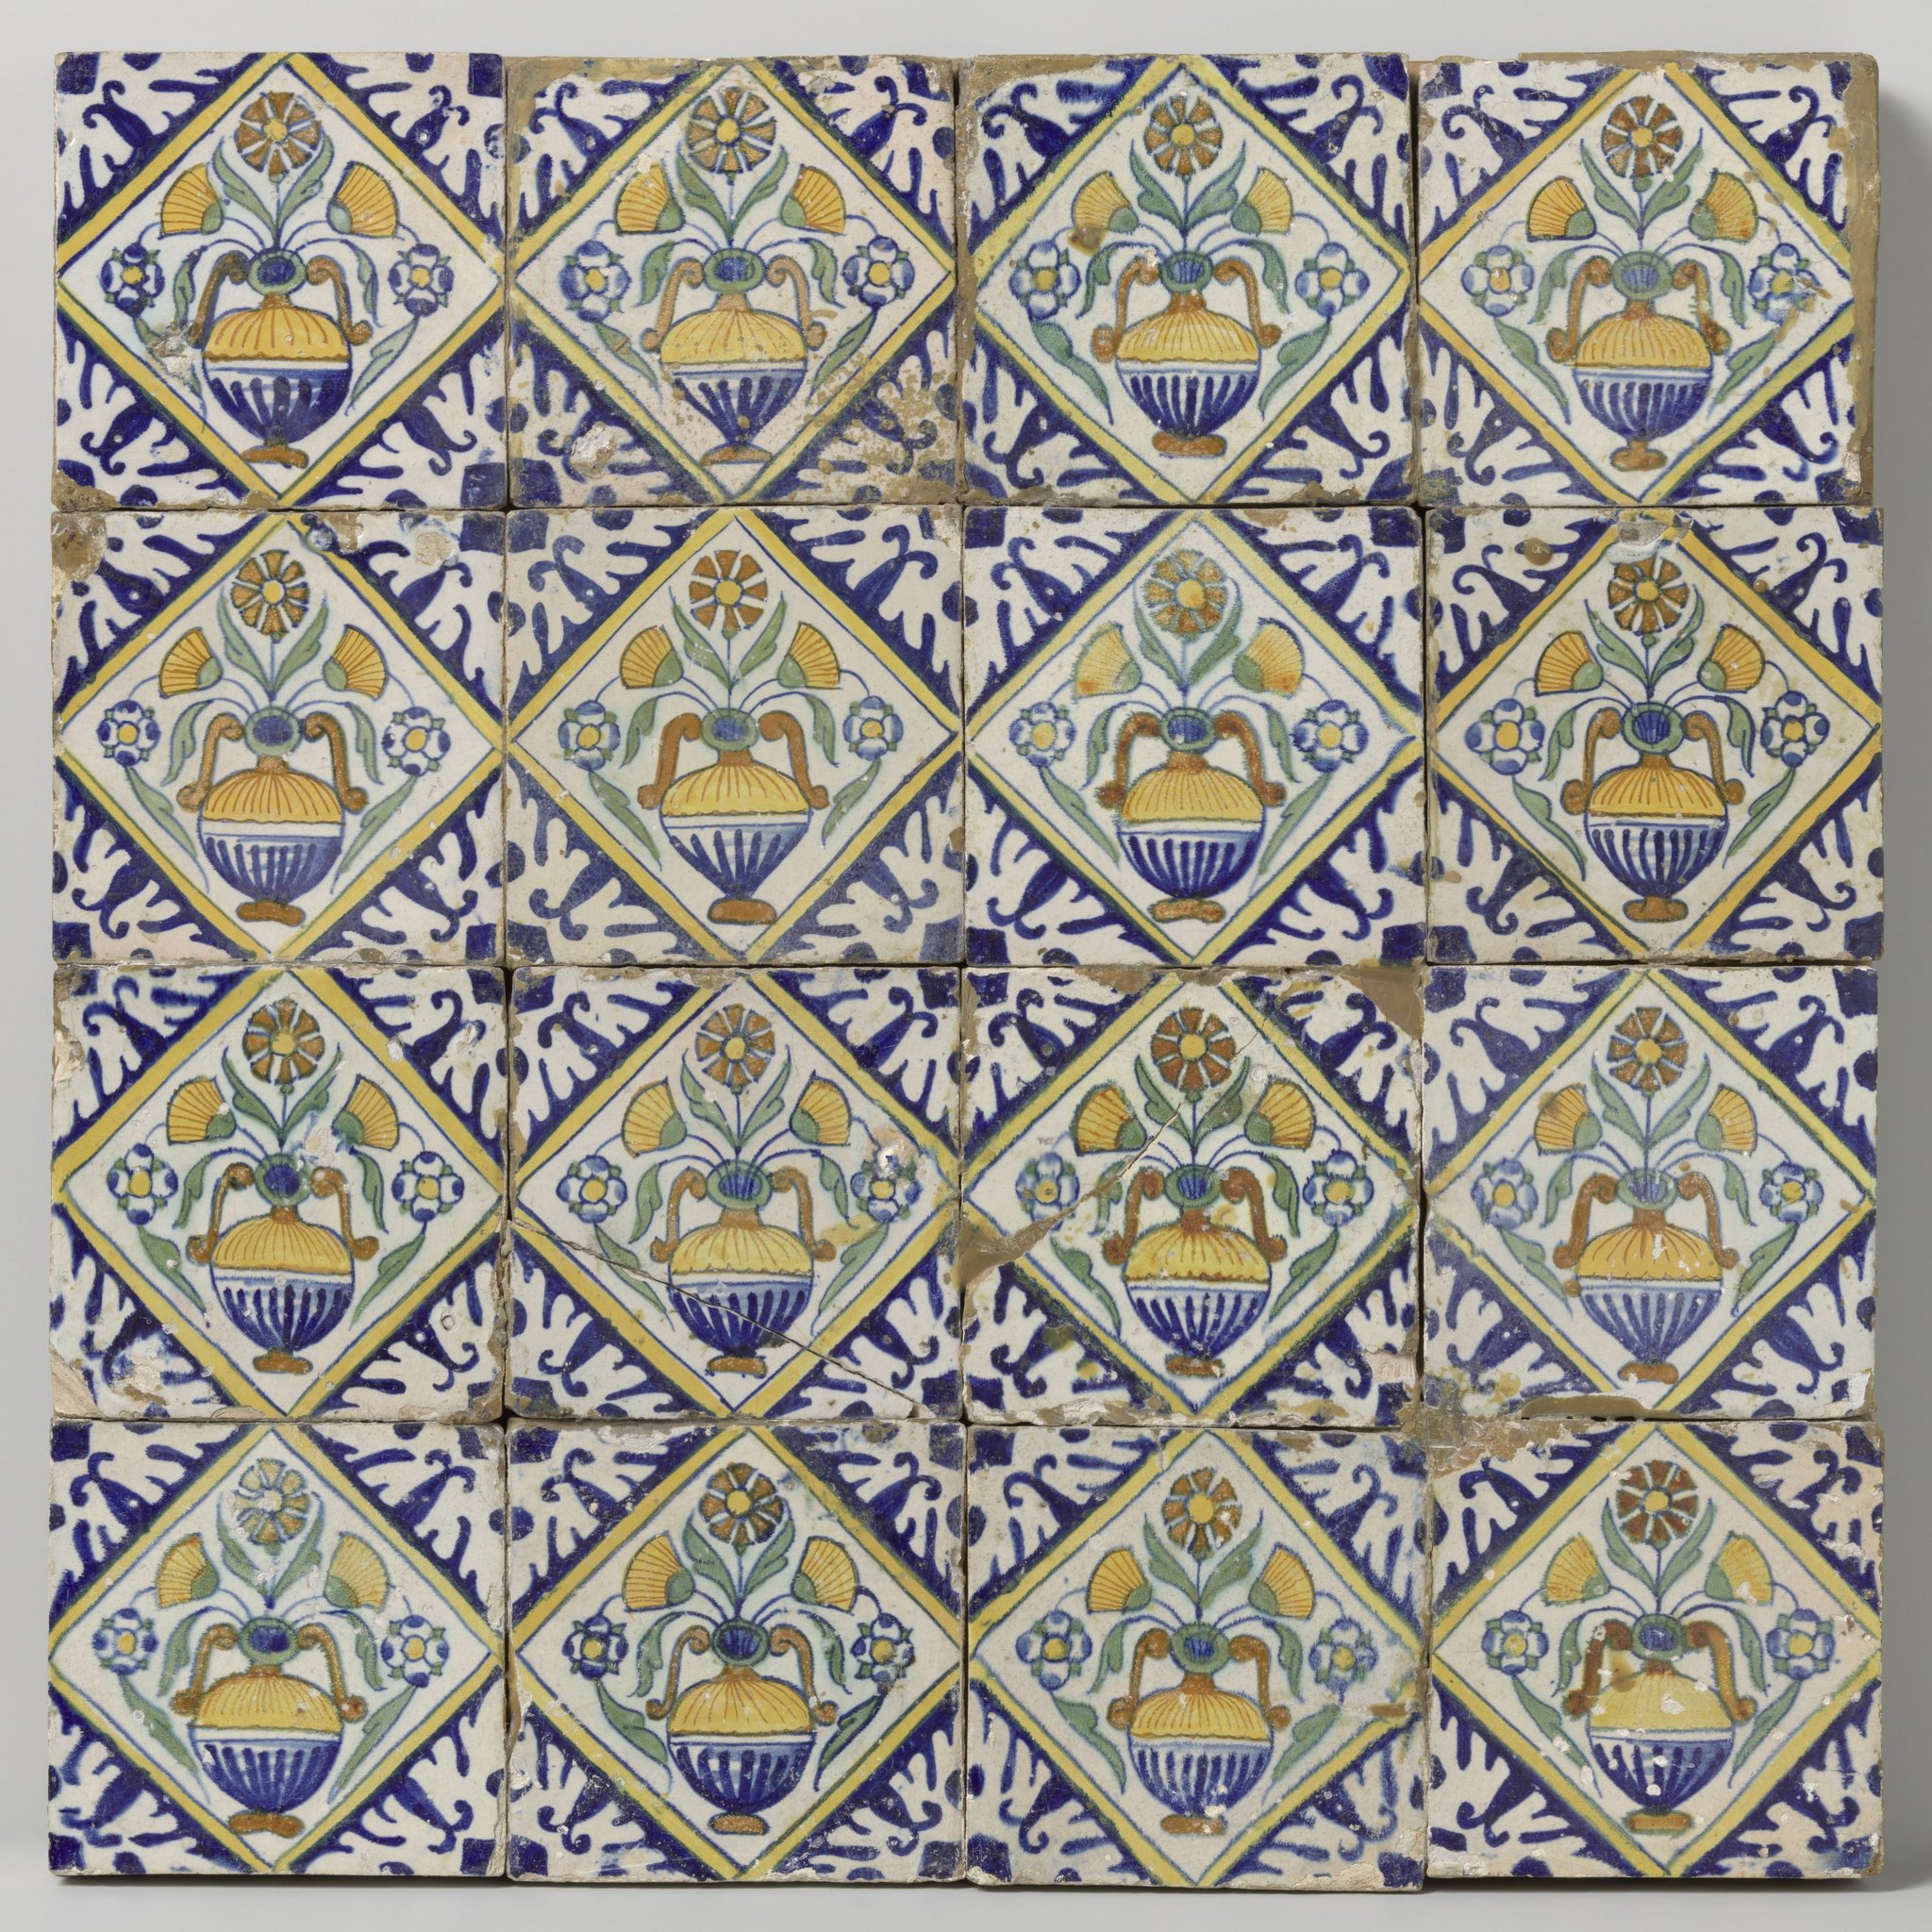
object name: tile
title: Veld van zestien tegels met bloempotten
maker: Anonymous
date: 1580-1625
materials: earthenware, glaze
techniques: maiolica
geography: netherlands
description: Veld van zestien tegels (4 x 4) elk met een veelkleurige (blauw, oranje, groen en geel) bloempot binnen een kwadraat omlijsting. In de hoeken, ornament in vultechniek.